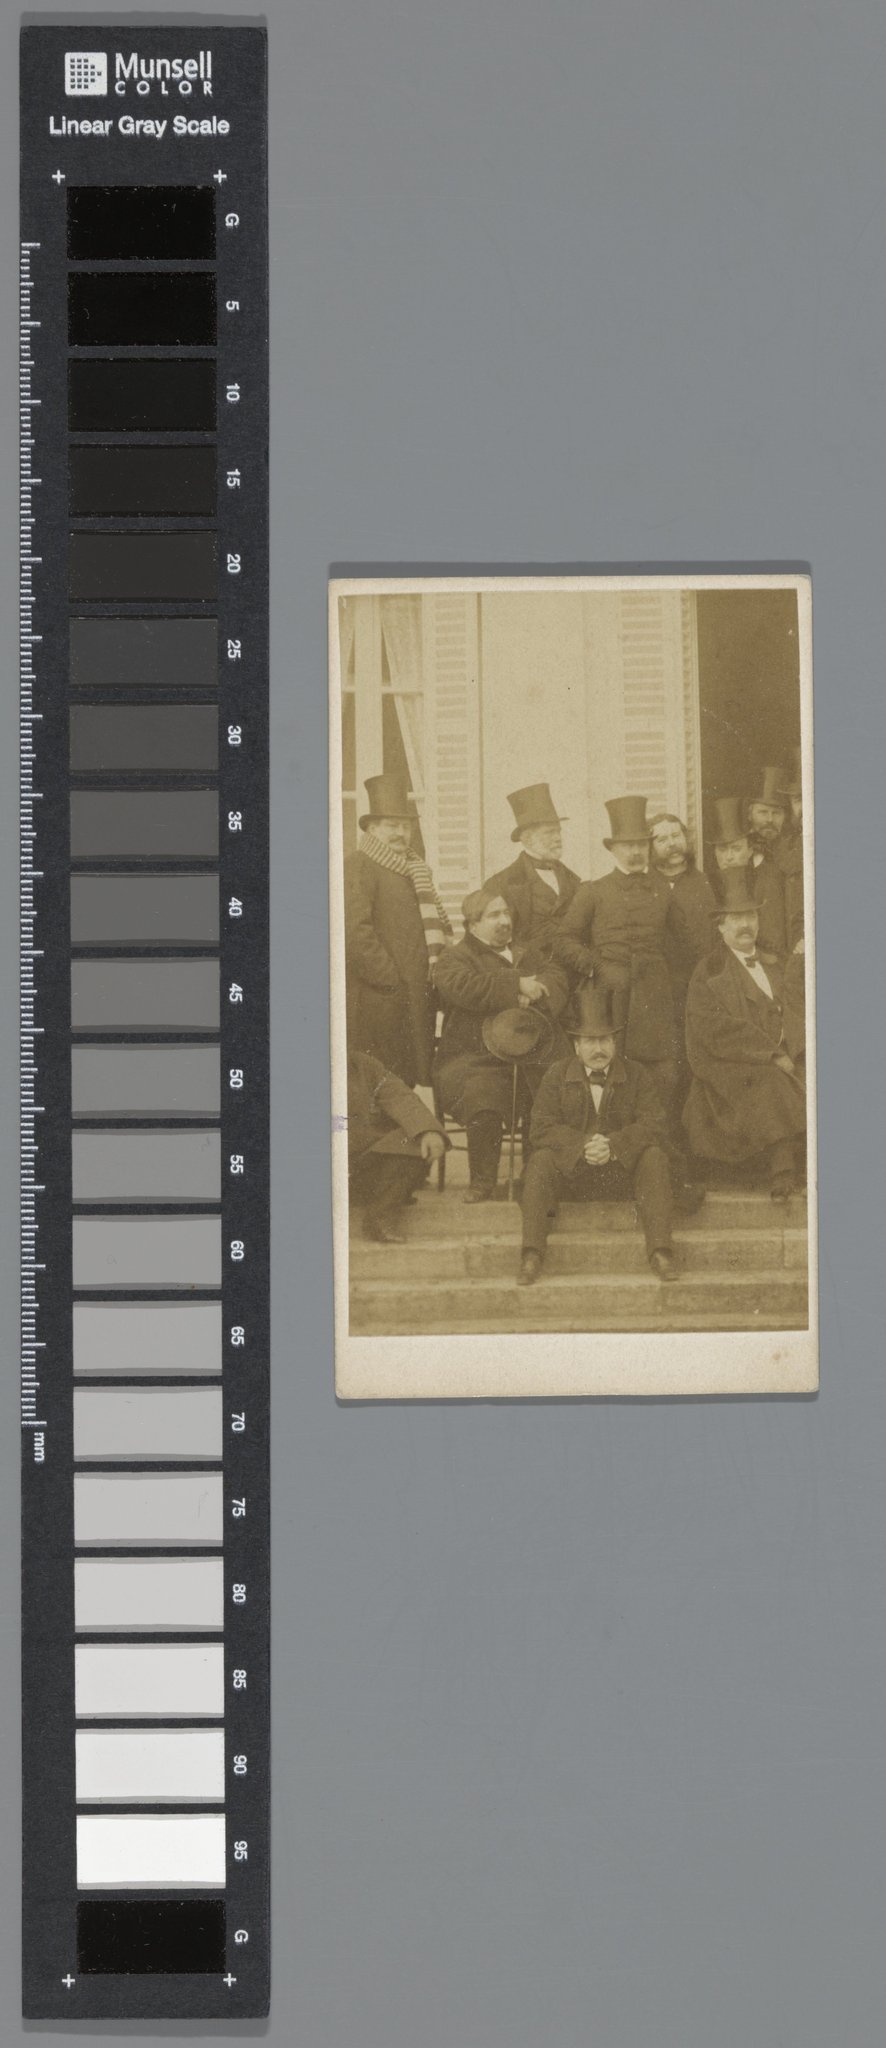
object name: photograph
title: Journalisten op een trap, alsmede de wetenschapper en politicus Achille Jubinal (zittend links)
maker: Anonymous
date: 1860-1865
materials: cardboard, paper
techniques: albumen print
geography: paris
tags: paris, journalist, reporter, historical persons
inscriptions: inscription: ‘?/ Ce sont surement des/ journalistes au grande/ partie/ Celui qui est assis/ à gauche est/ Achille Jubinal’